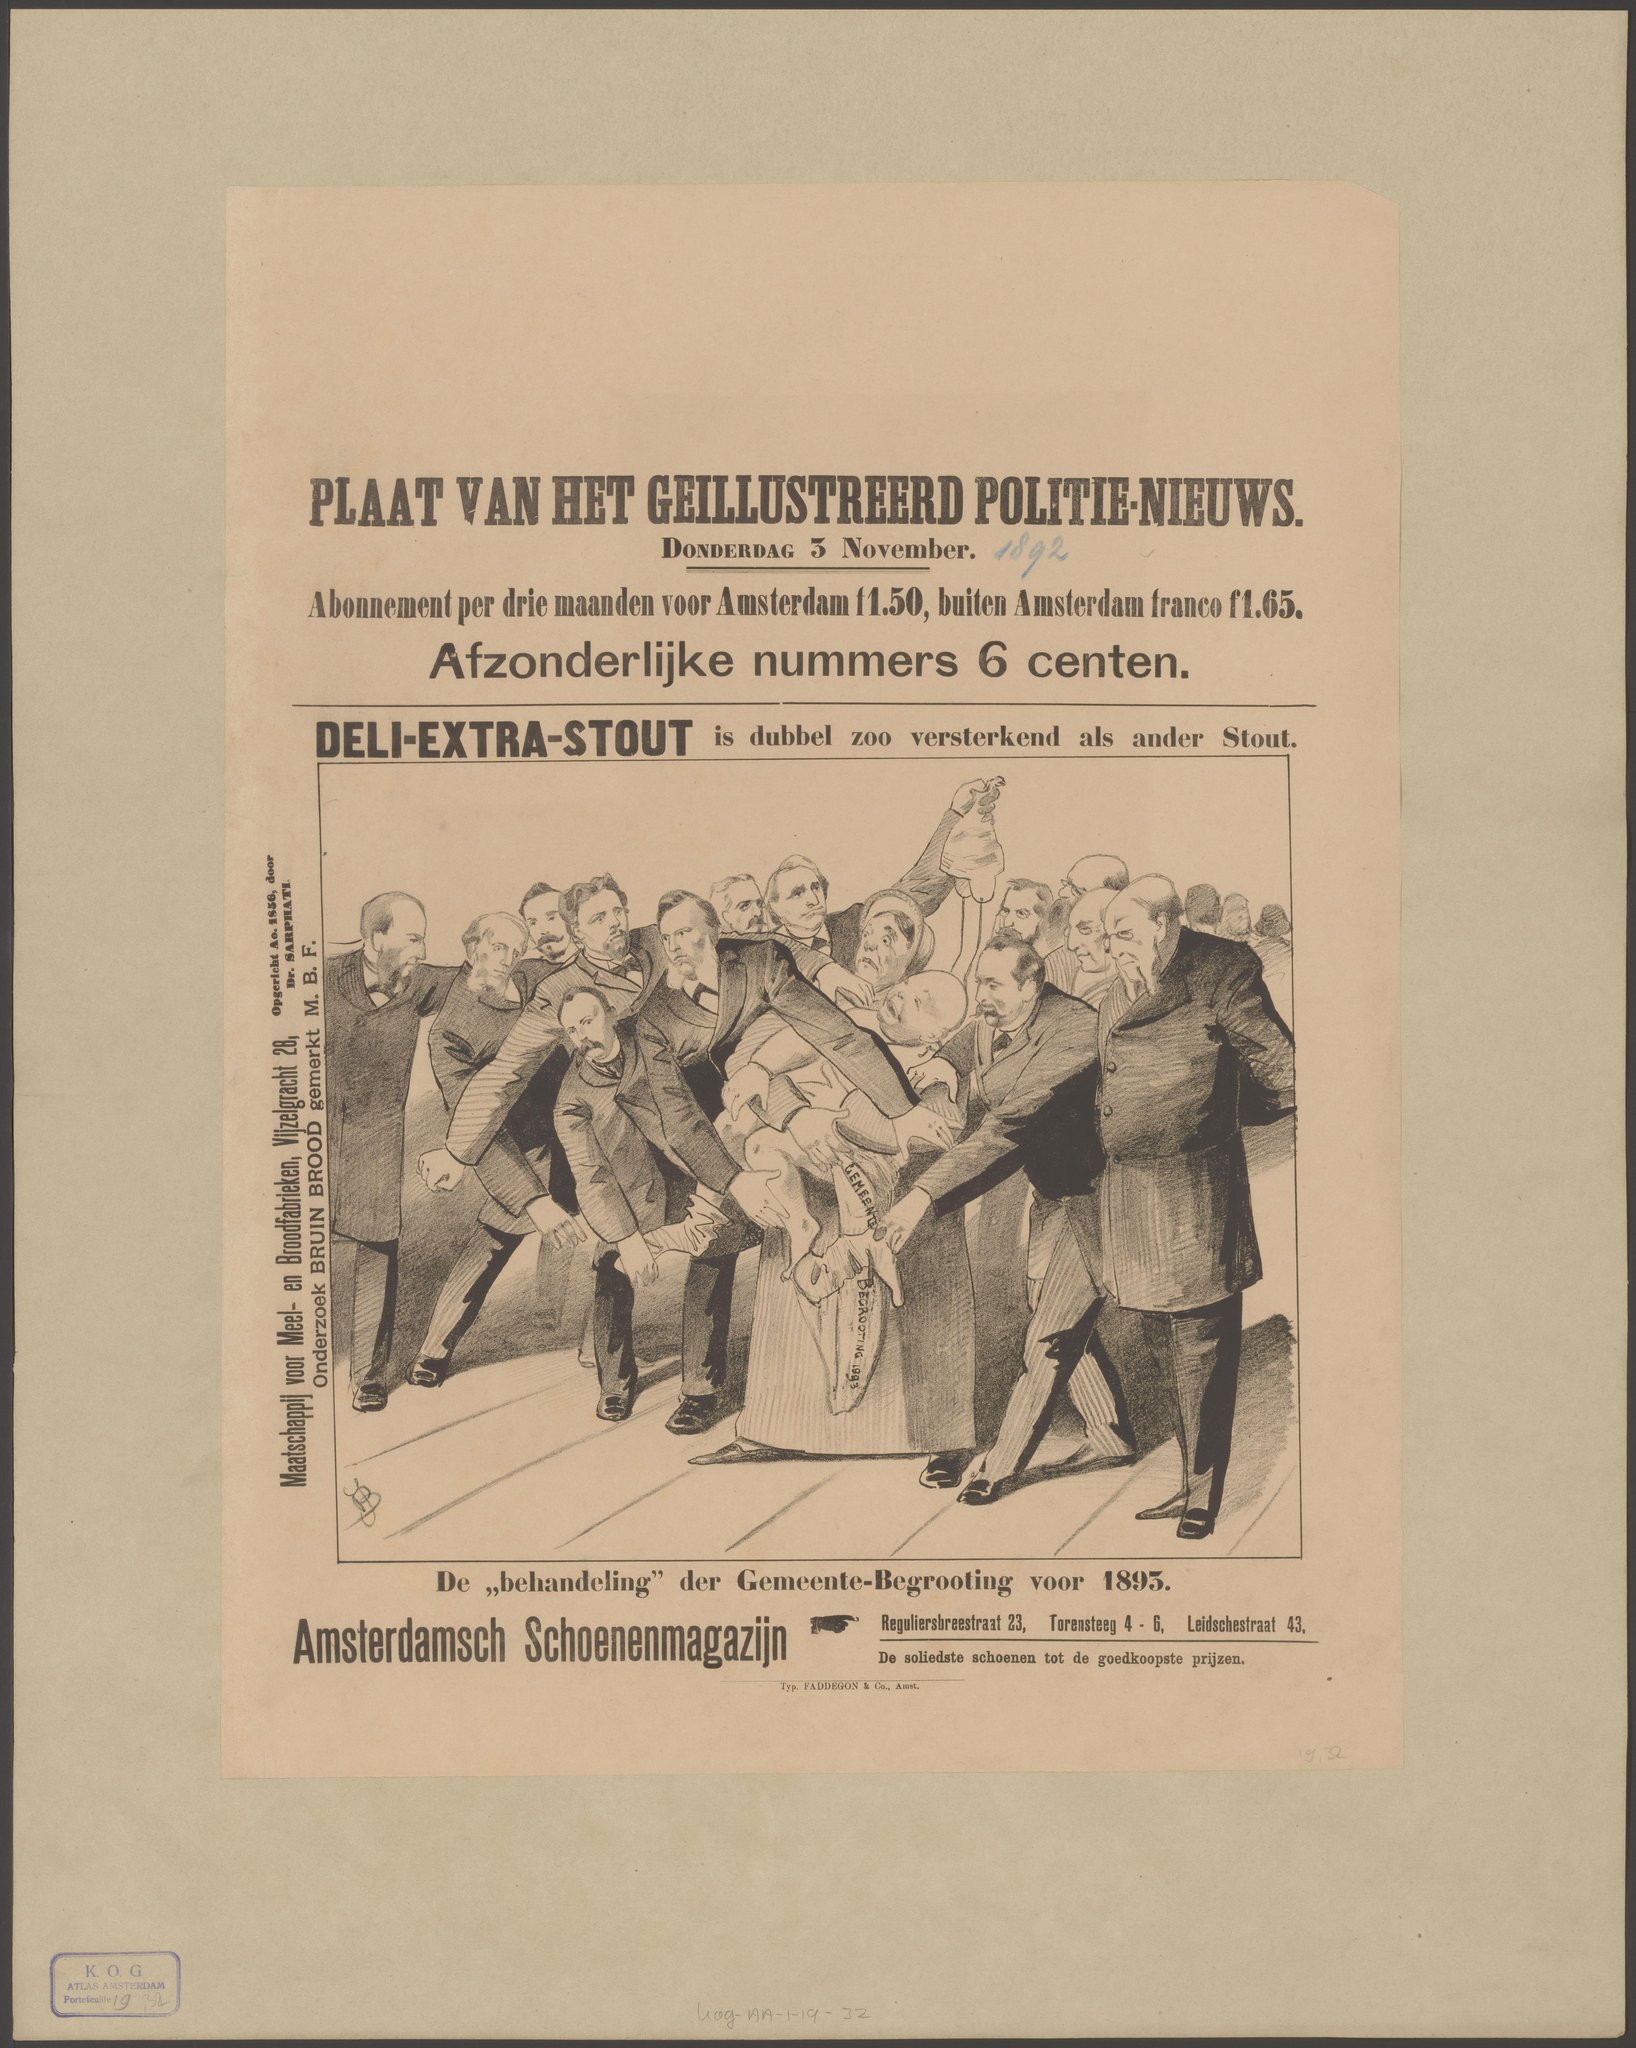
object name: cartoon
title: Spotprent op de gemeentelijke begroting van Amsterdam van 1893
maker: johan braakensiek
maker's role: draughtsman, print maker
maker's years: 1858-1940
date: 1892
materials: paper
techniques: letterpress printing, lithograph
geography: amsterdam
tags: city council, political caricatures and satires, amsterdam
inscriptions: collector's mark: ‘19,32’ Lugt 1641b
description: Onderwerpsrubriek binnen de Atlas Amsterdam: Herinneringen aan regeringsleden en hunne huisgezinnen [na 1800].